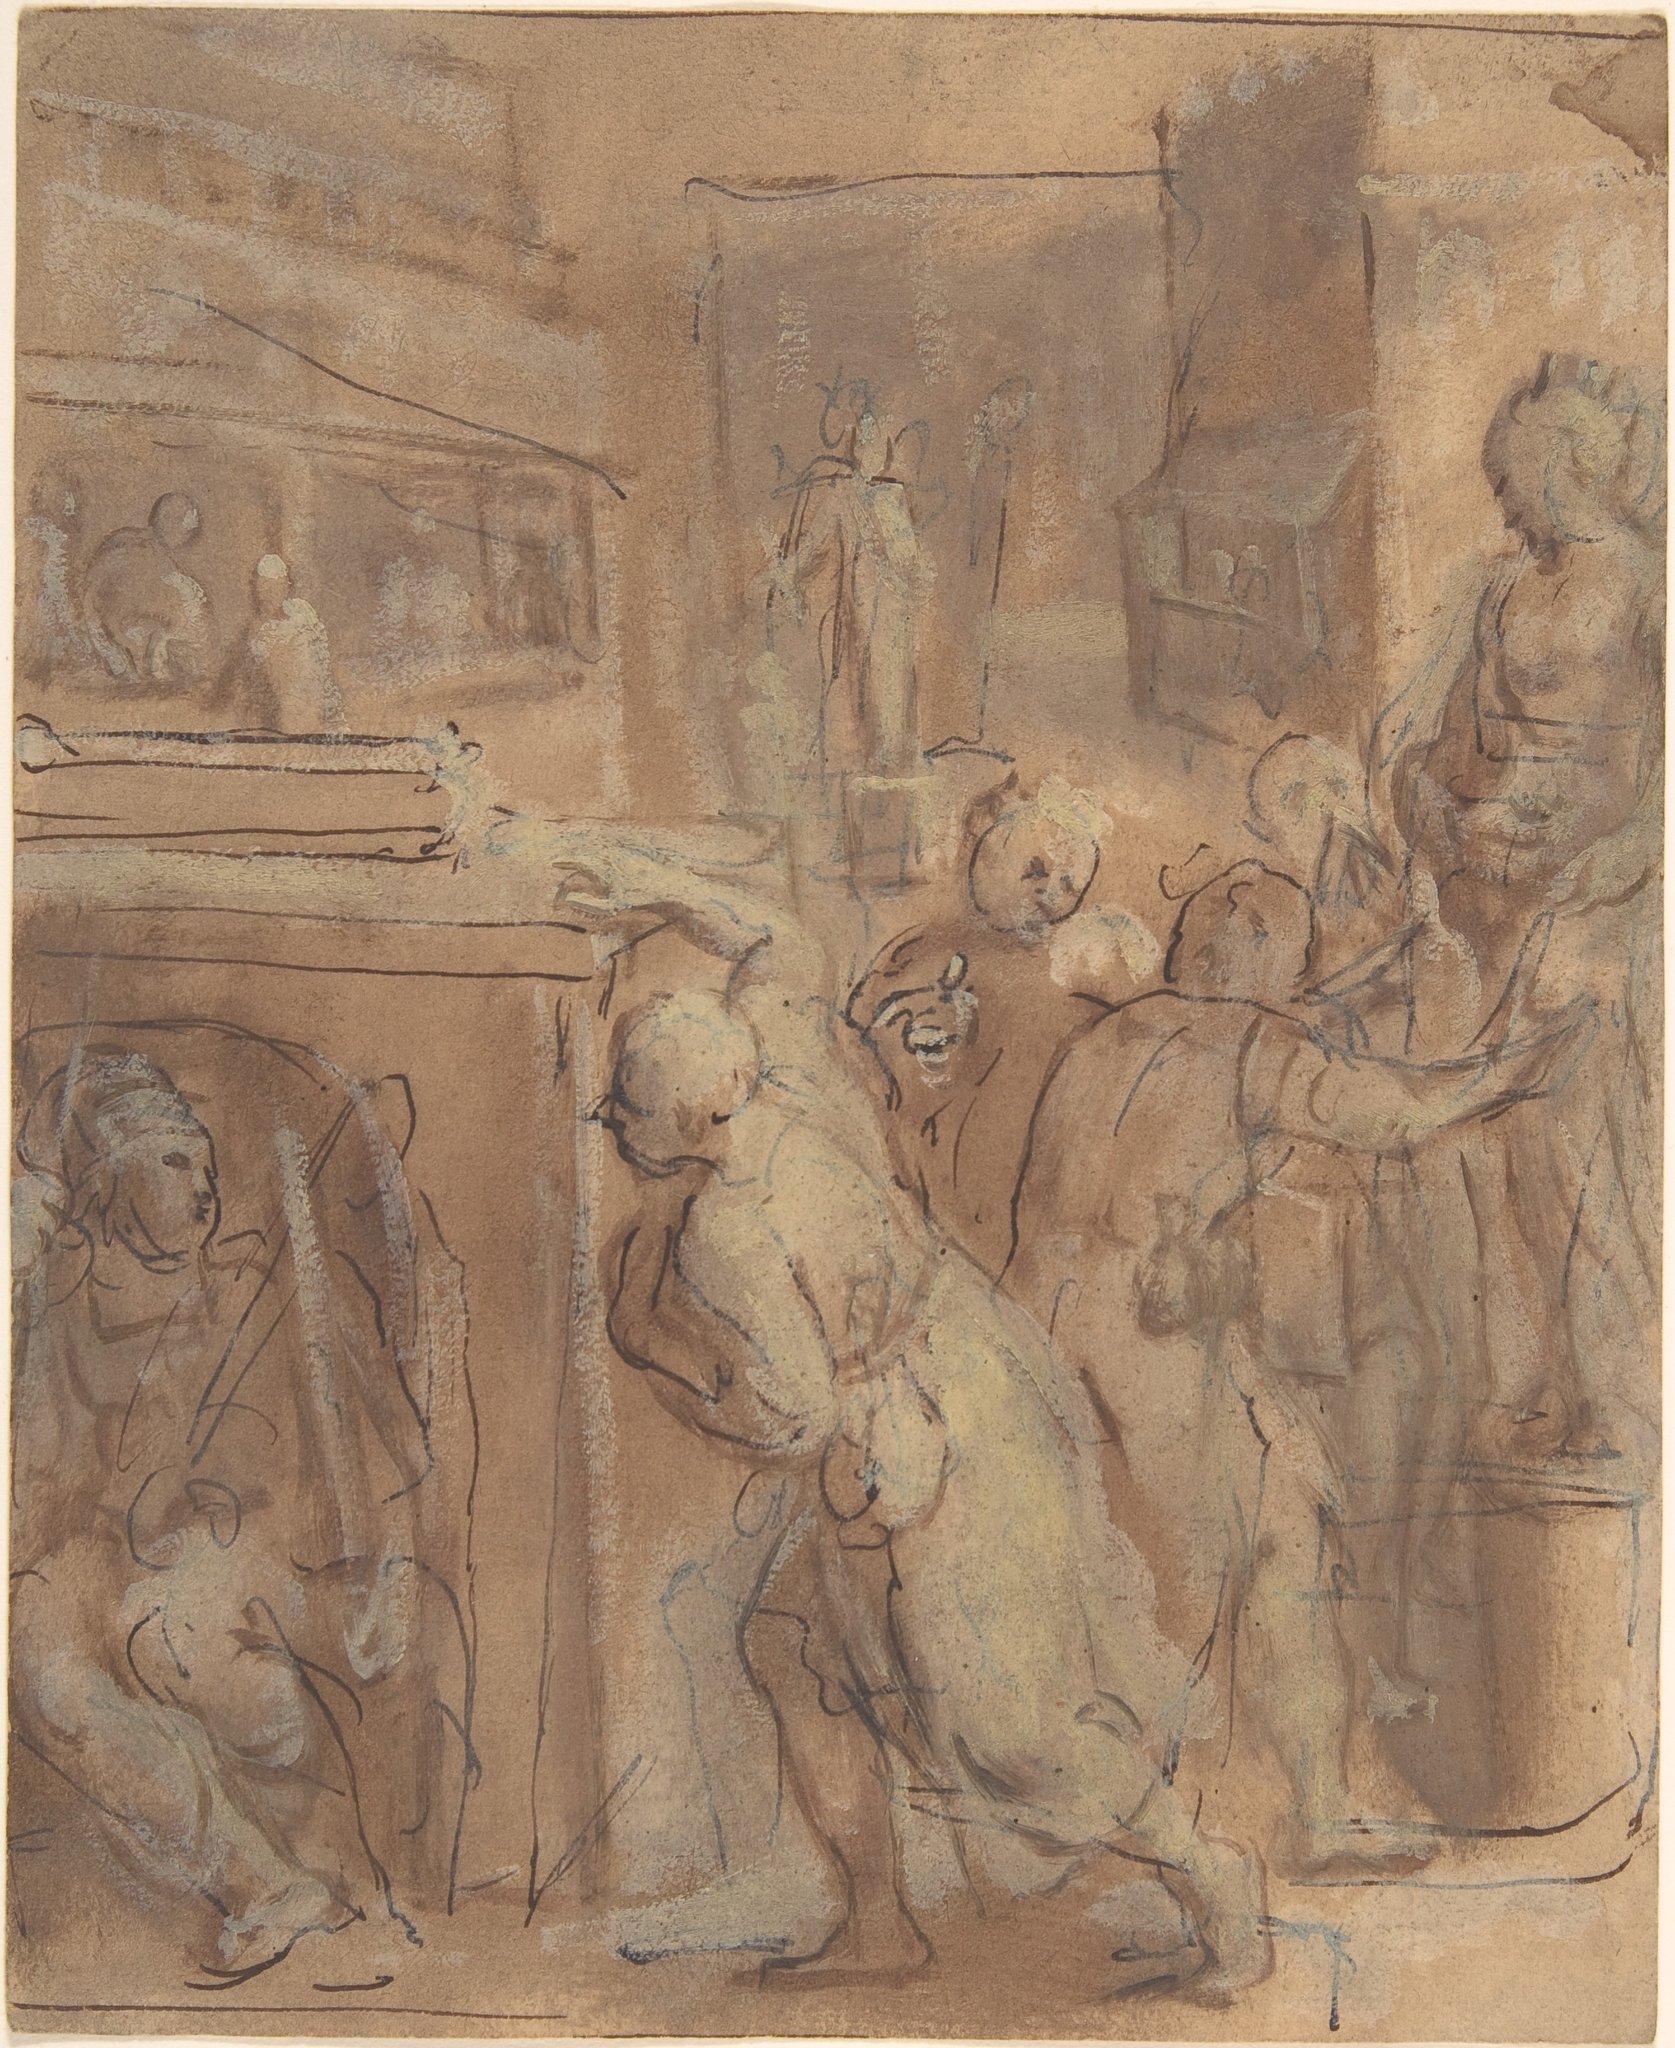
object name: drawing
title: Emblematic Scene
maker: otto van veen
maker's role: artist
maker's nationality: netherlandish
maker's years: 1556-1629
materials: ink, oil, paper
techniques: brush, pen, tinting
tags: men,women